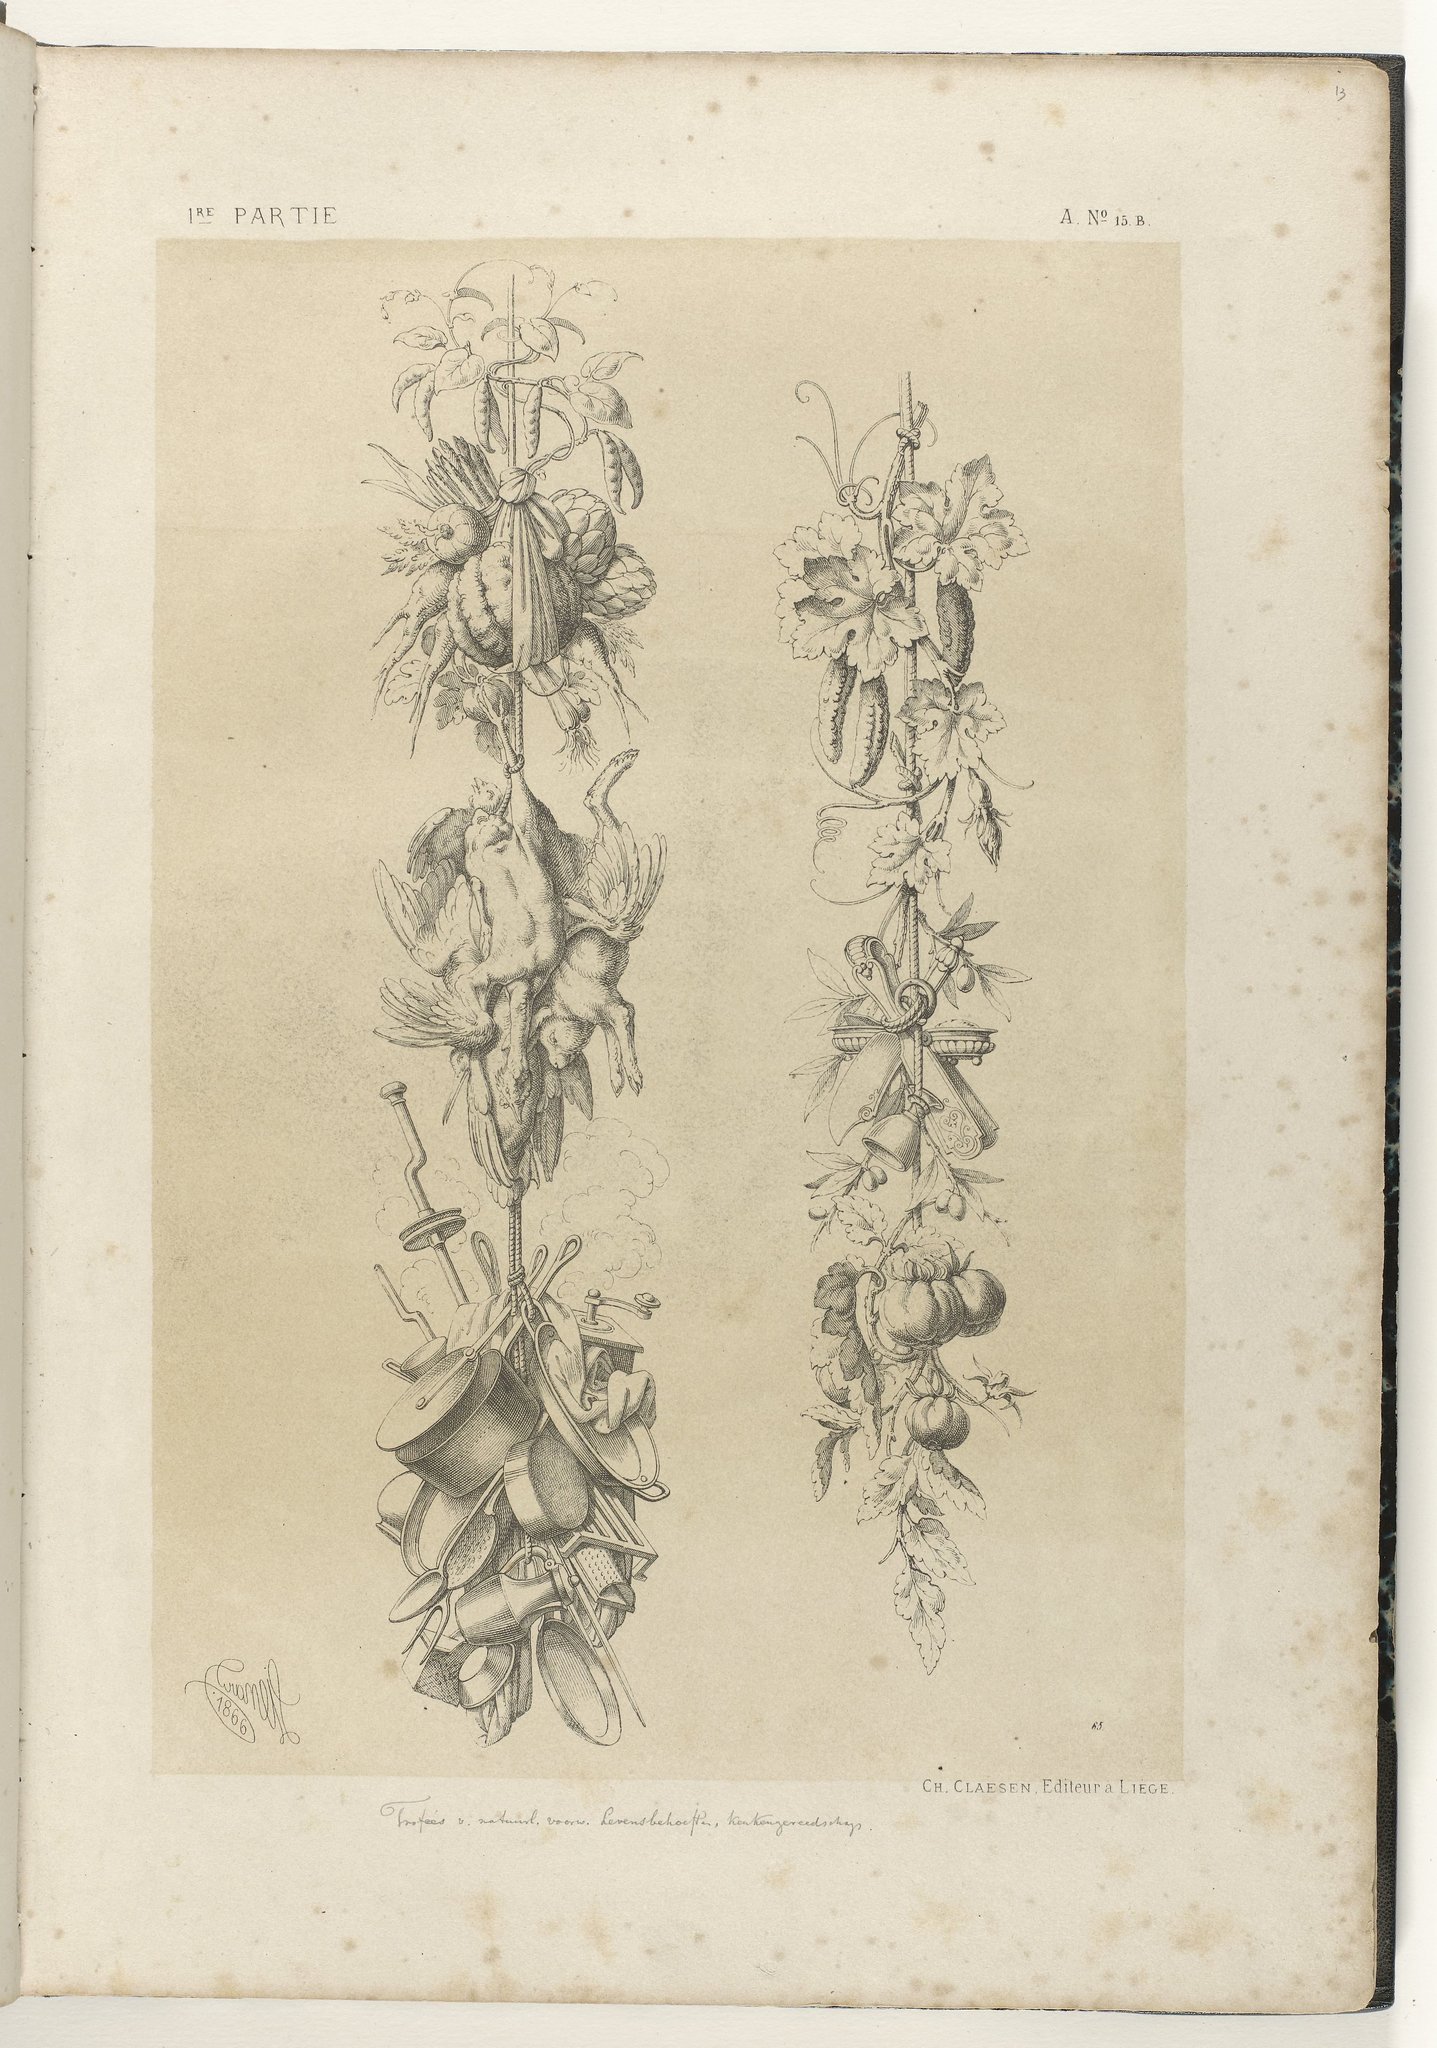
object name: print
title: Twee trofeeën van groente, gevogelte en keukengerei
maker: michel liénard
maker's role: print maker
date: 1866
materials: paper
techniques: tone lithography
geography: liège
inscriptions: annotation: ‘Trofeés v. natuurl. voorw. Levensbehoeften, Keukengereedschap.’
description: Linksboven: 1re partie, rechtsboven: A. N° 15.B., rechtsonder: 65.